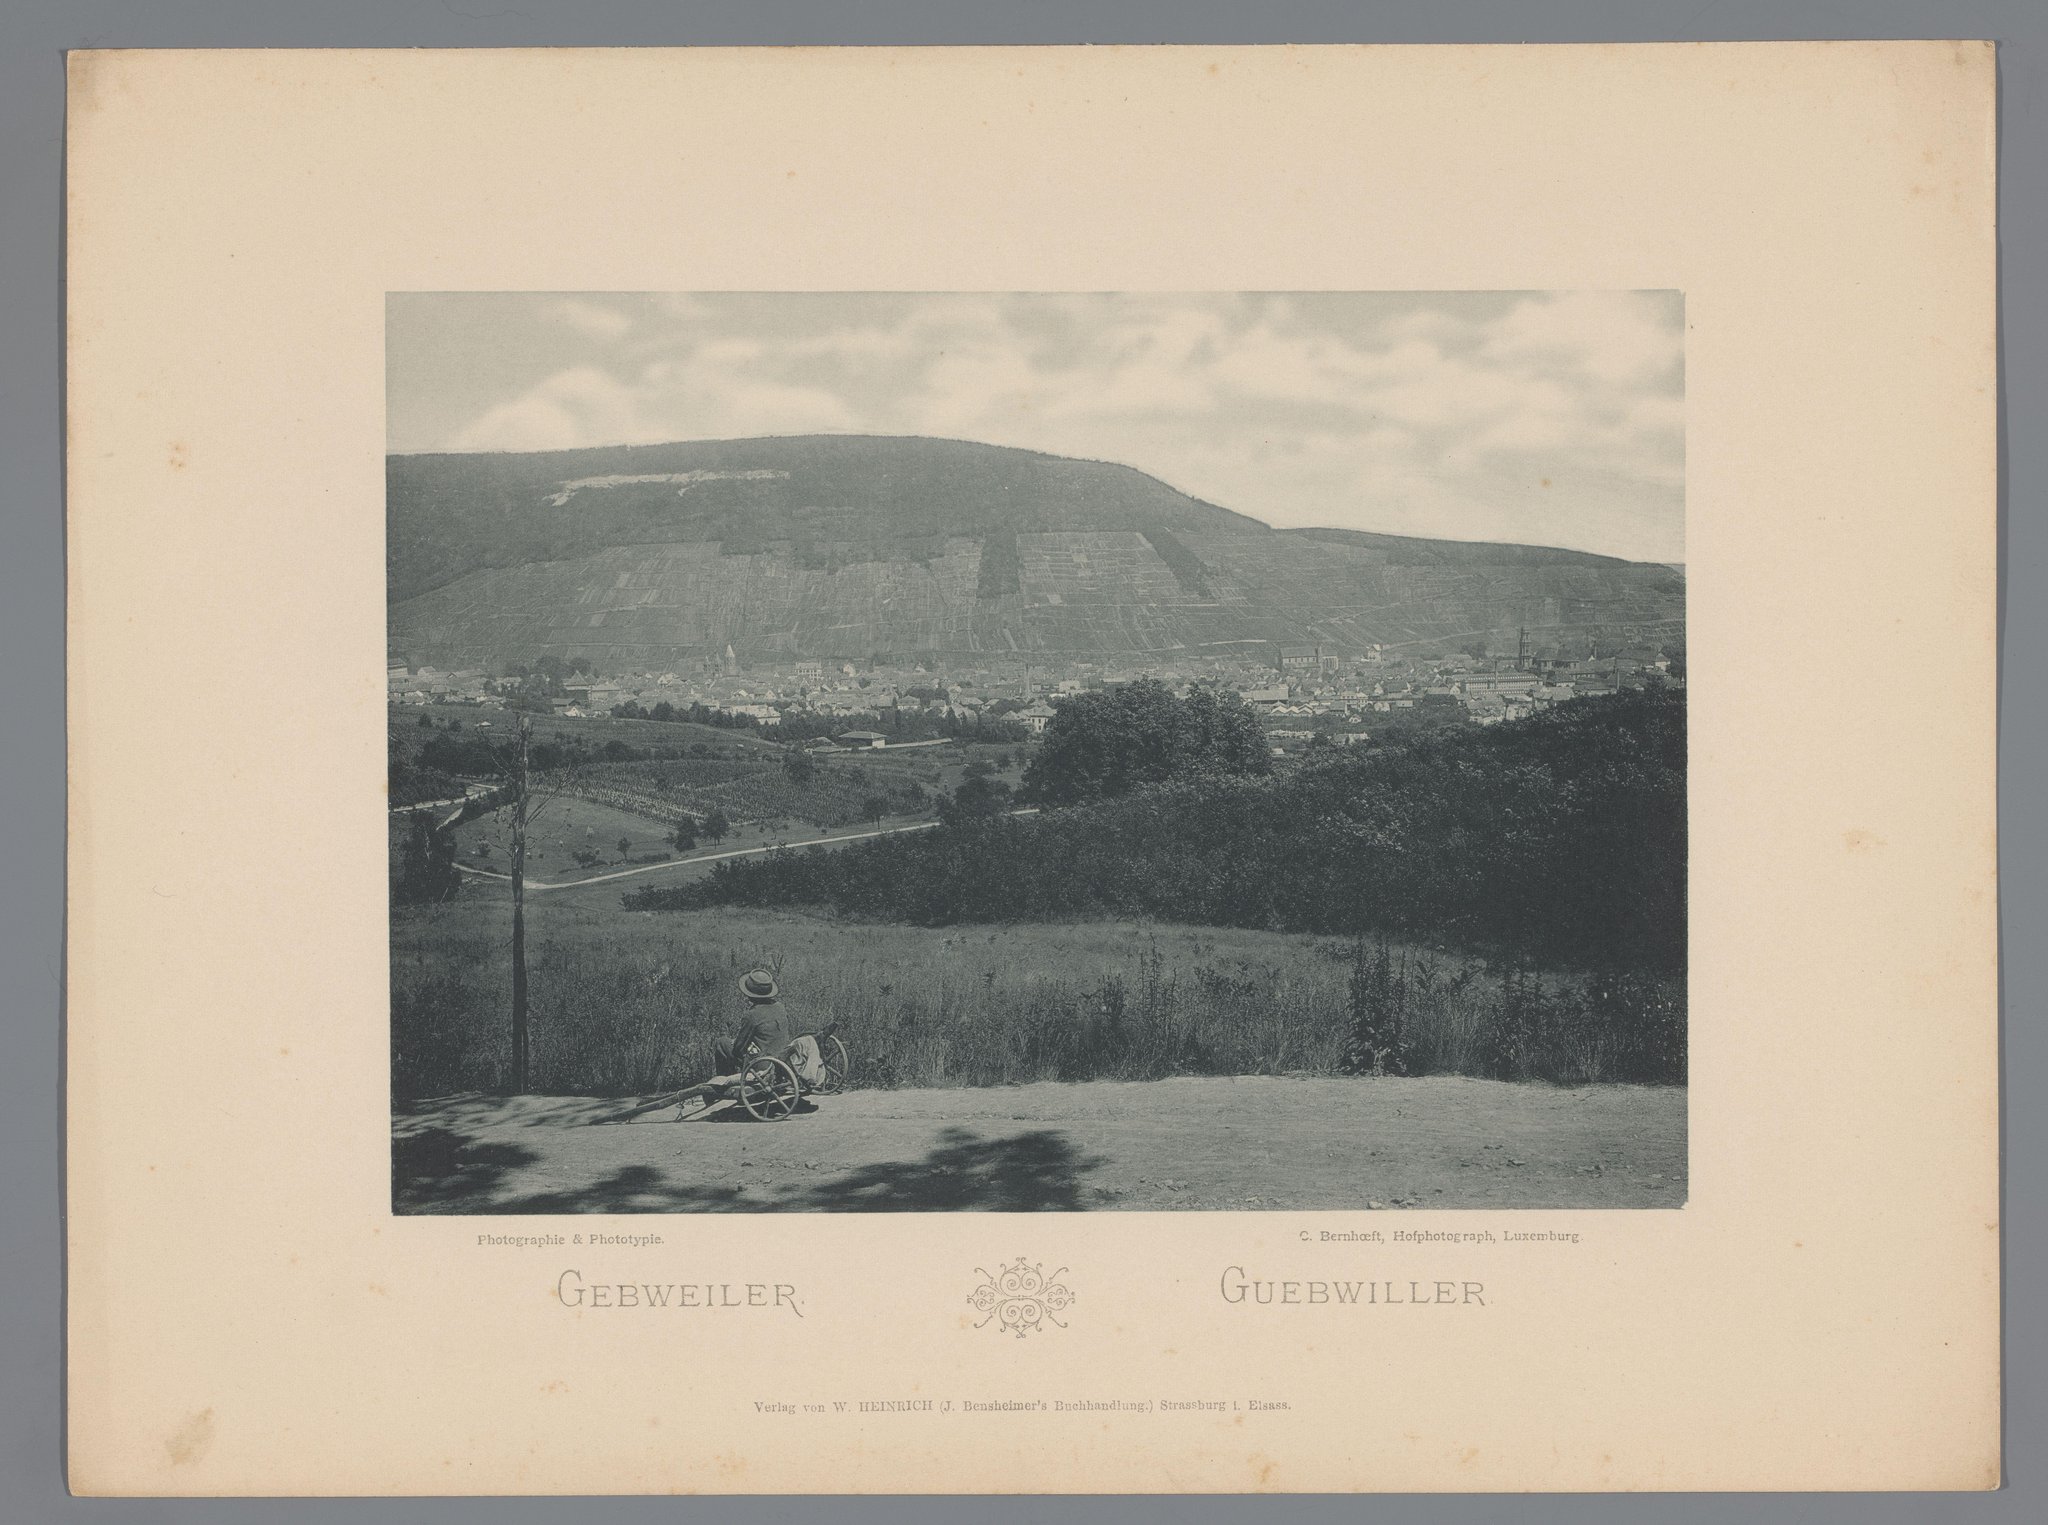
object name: photomechanical print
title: Gebweiler, Guebwiller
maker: charles bernhoeft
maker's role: publisher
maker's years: 1859-1933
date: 1889-1894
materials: paper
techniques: photograph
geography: luxembourg city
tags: street (+ city(-scape) with figures, staffage)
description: Deze prent maakt deel uit van een omslag met 100 prenten.